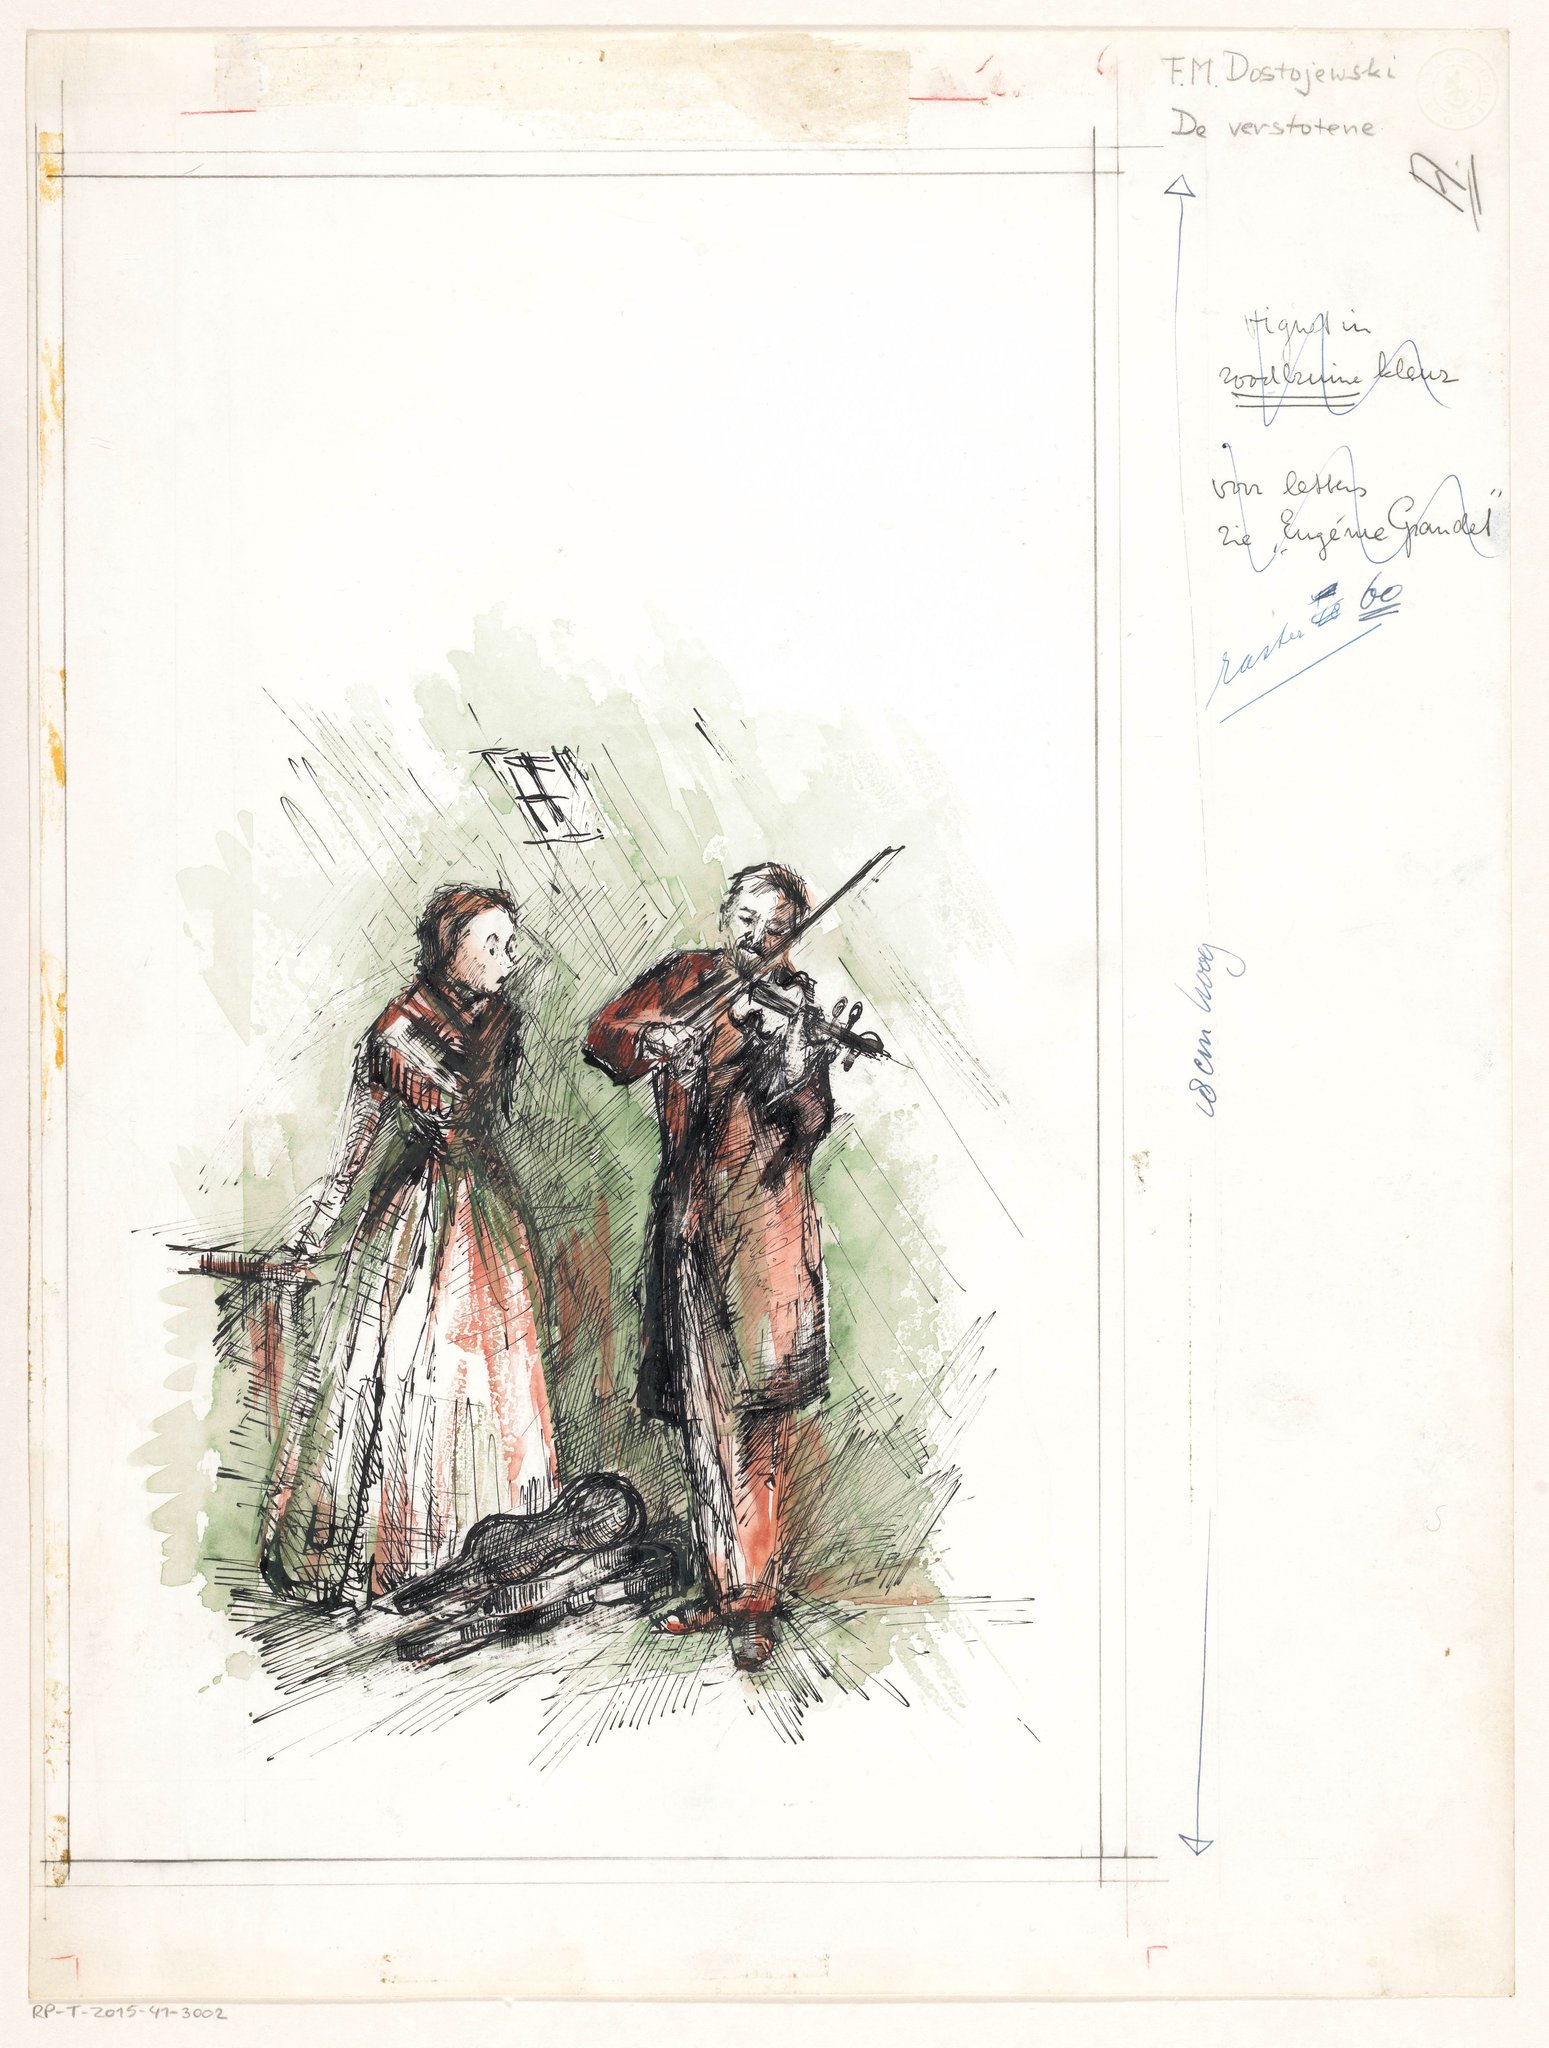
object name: boekillustratie ontwerp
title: Vrouw en vioolspelende man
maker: Anonymous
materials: ink, paper, pencil, watercolor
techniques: brush, pen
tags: violin, fiddle (+ artist at work)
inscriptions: collector's mark: Lugt 2228a, factory mark: ‘SCHOELLER/ PAROLE’, annotation: ‘F.M. Dostojewski,/ De verstotene/ vignet in/ roodbruine kleur/ voor letters/ zie "Eugénie Grandet"’, :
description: Een man speelt viool. Zijn vioolkist ligt open op de grond. Een vrouw kijkt toe. Met haar rechterhand leunt ze op een tafel.